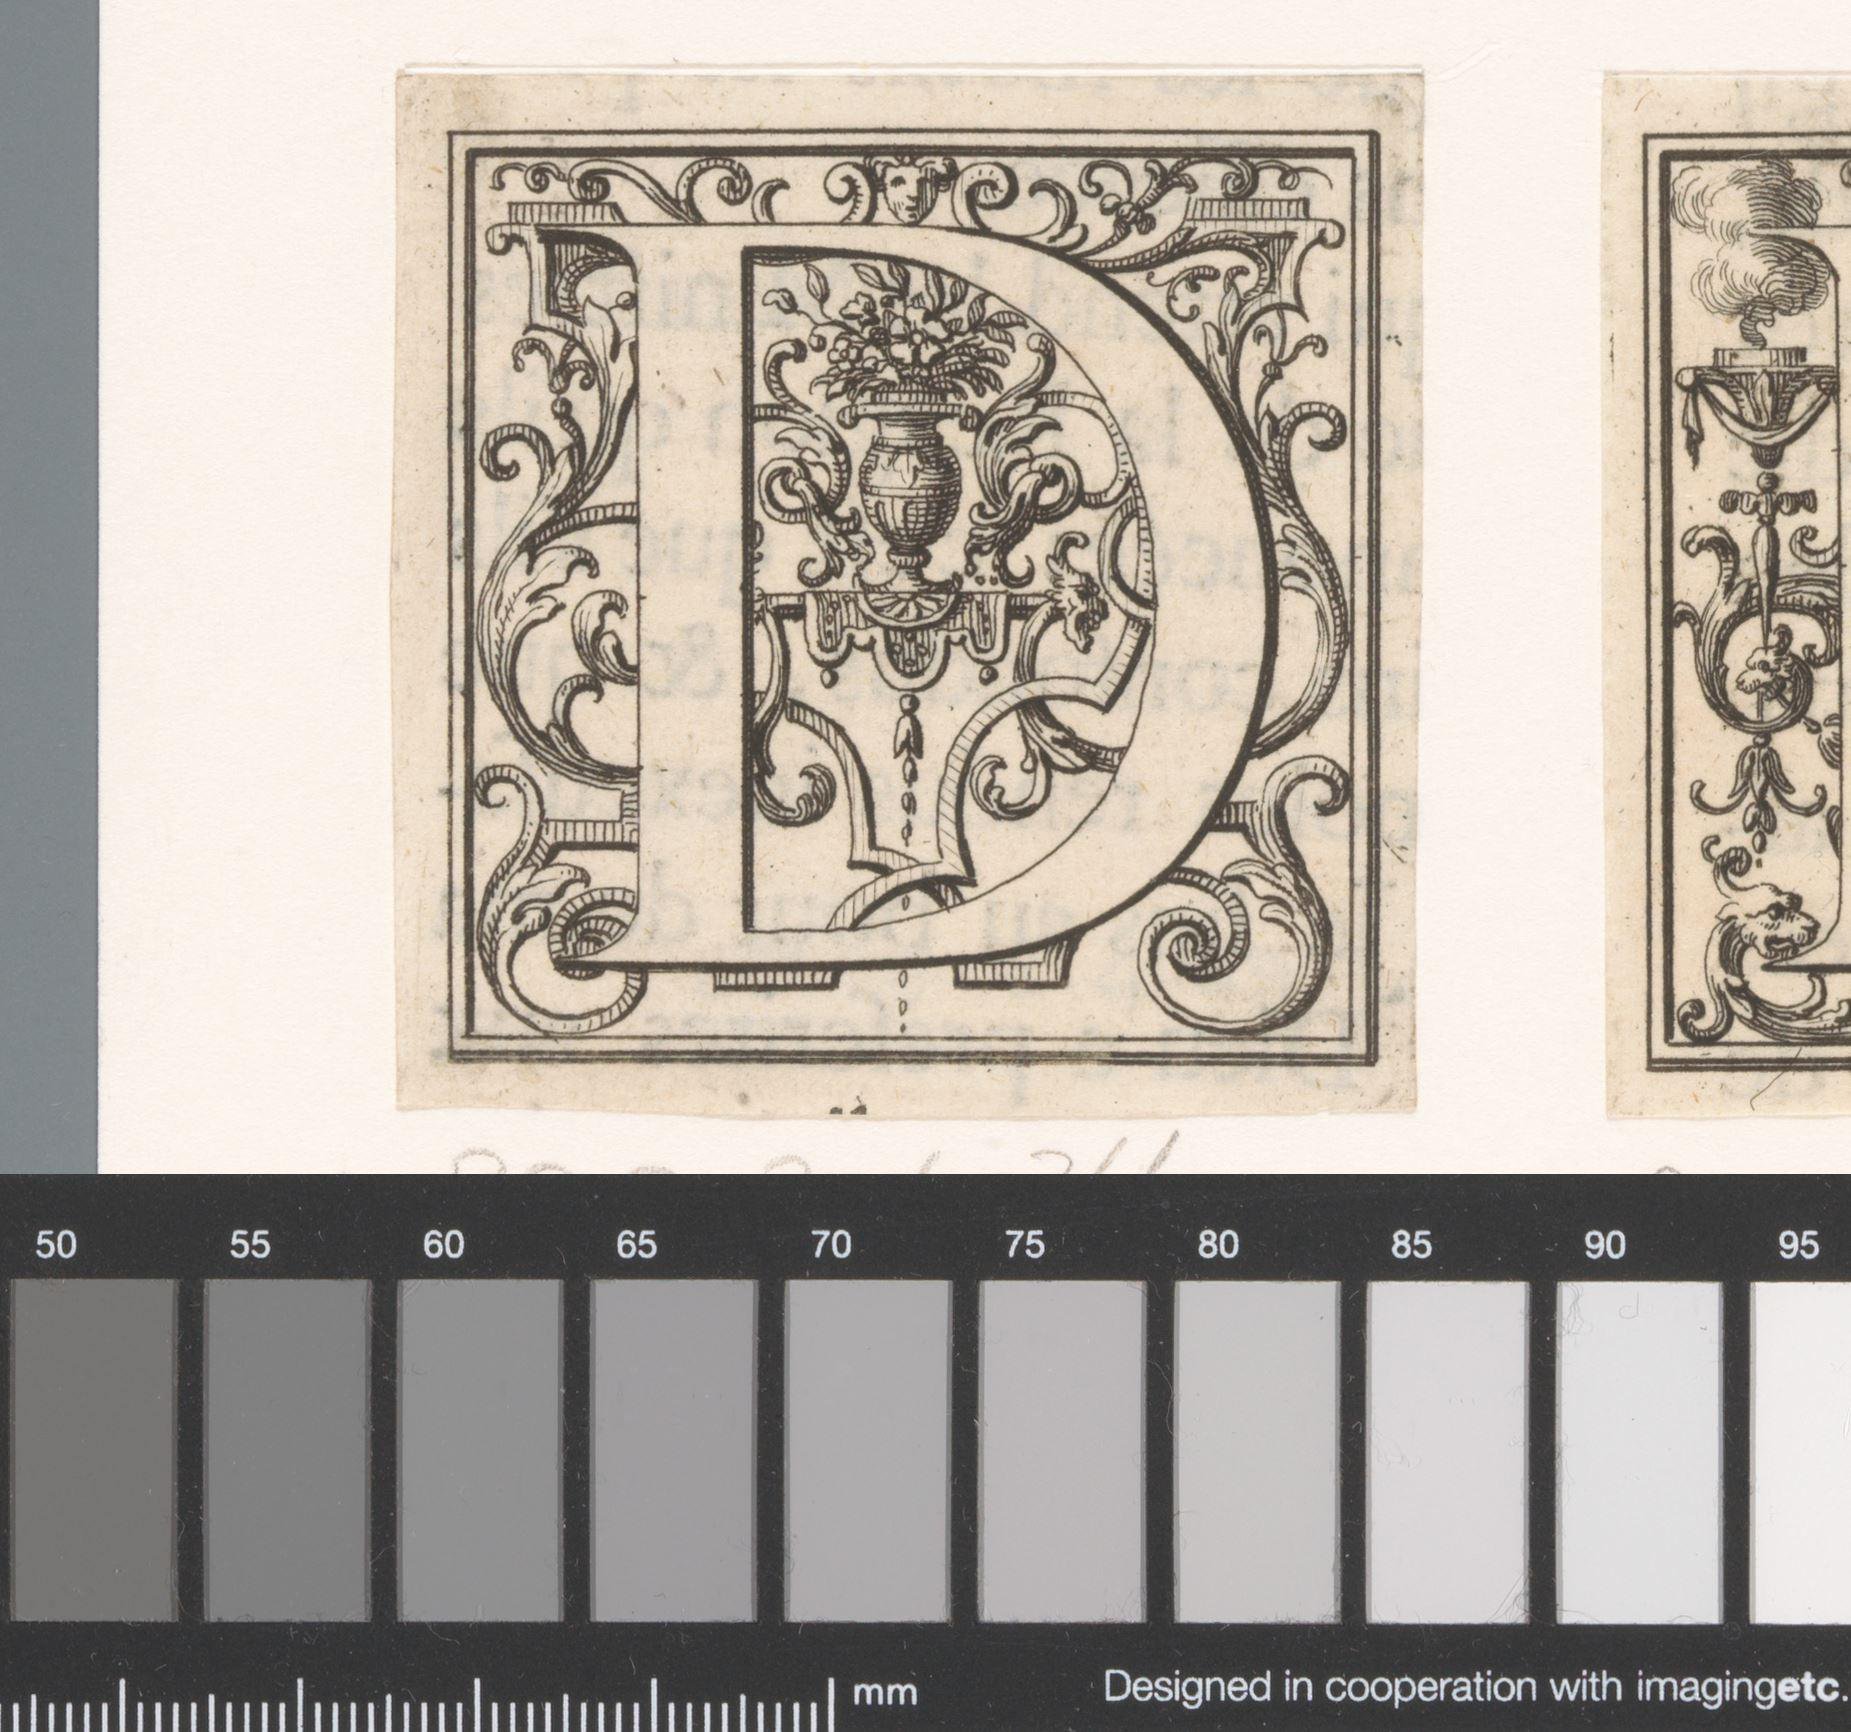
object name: print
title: Letter D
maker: Anonymous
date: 1700-1799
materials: paper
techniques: etching, letterpress printing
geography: france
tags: fancy letters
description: Letter D tegen een achtergrond met vlechtwerk en een bloemenvaas.